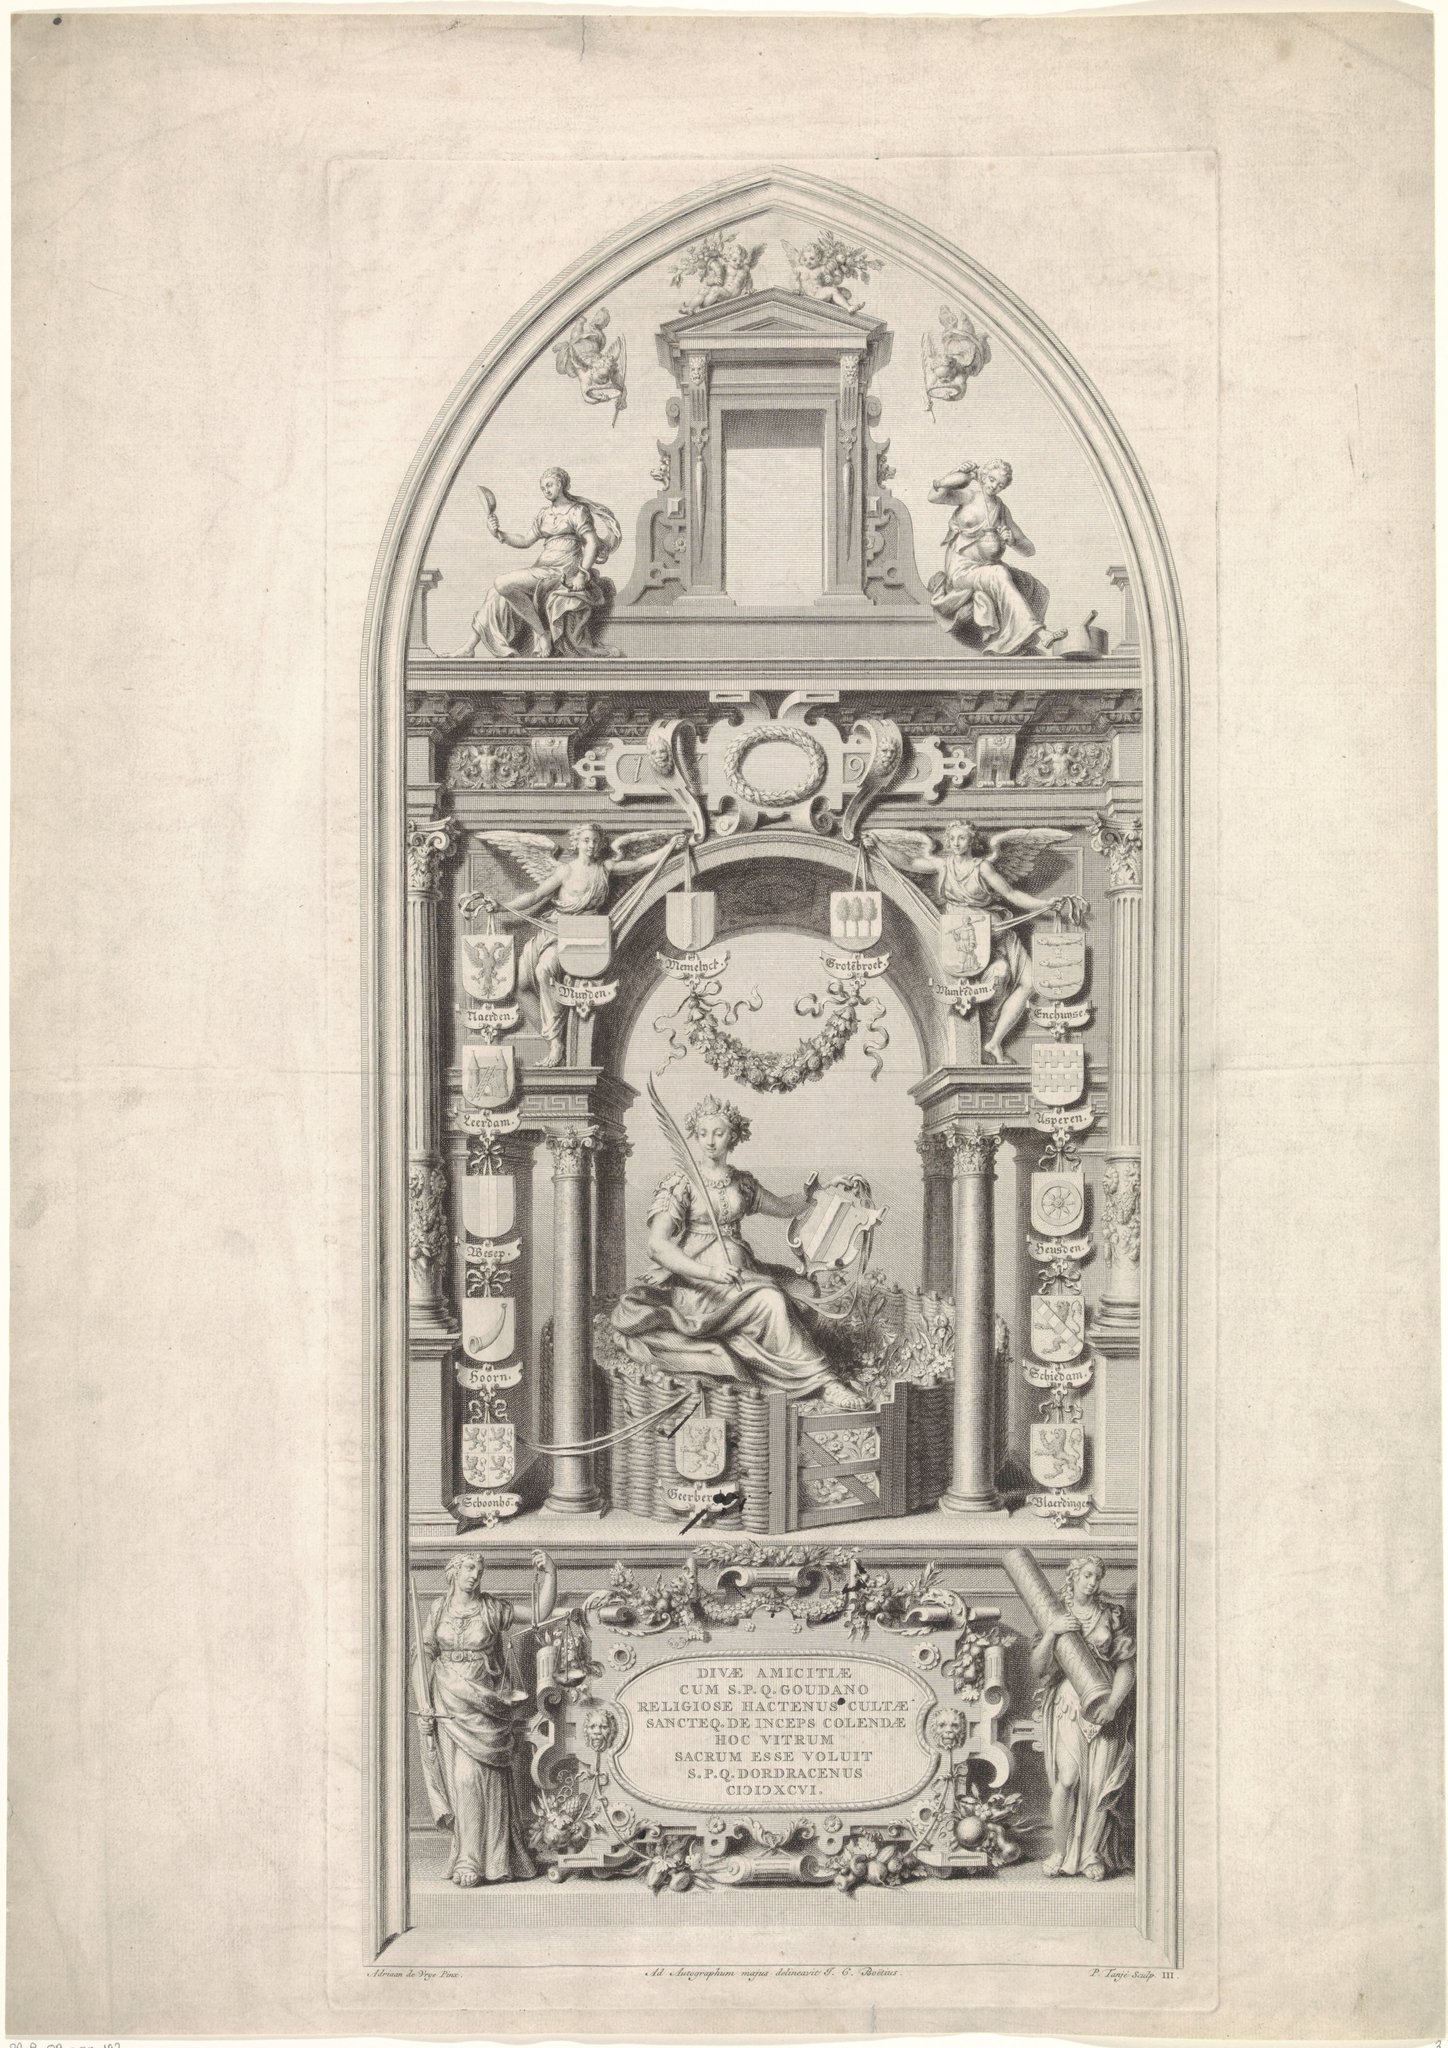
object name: print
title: Goudse glazen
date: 1738-1754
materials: paper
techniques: engraving, etching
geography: amsterdam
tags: personification of a city, town-patron(ess), church-window, e.g. rose-window, the four cardinal virtues, dordrecht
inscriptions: collector's mark: Lugt 2228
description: Het derde glasraam in de Sint-Janskerk te Gouda met de voorstelling van de Dordtse stedenmaagd. Zij zit in haar eigen tuin als middelpunt van Hollands territorium. Rondom vijftien stadswapens van steden die op de grenzen van het Hollandse gebied en de omringende provincies zijn gesitueerd. Boven de Voorzichtigheid, met spiegel en slang, en de Matigheid, die wijn met water mengt. Onderaan de Rechtvaardigheid met zwaard en weegschaal en de Standvastigheid met een zuil. Deze vier kardinale deugden verwijzen naar de trots van Dordrecht op haar deugdzame bestuur. De stad Dordrecht was de schenker van het glasraam aan de stad Gouda.